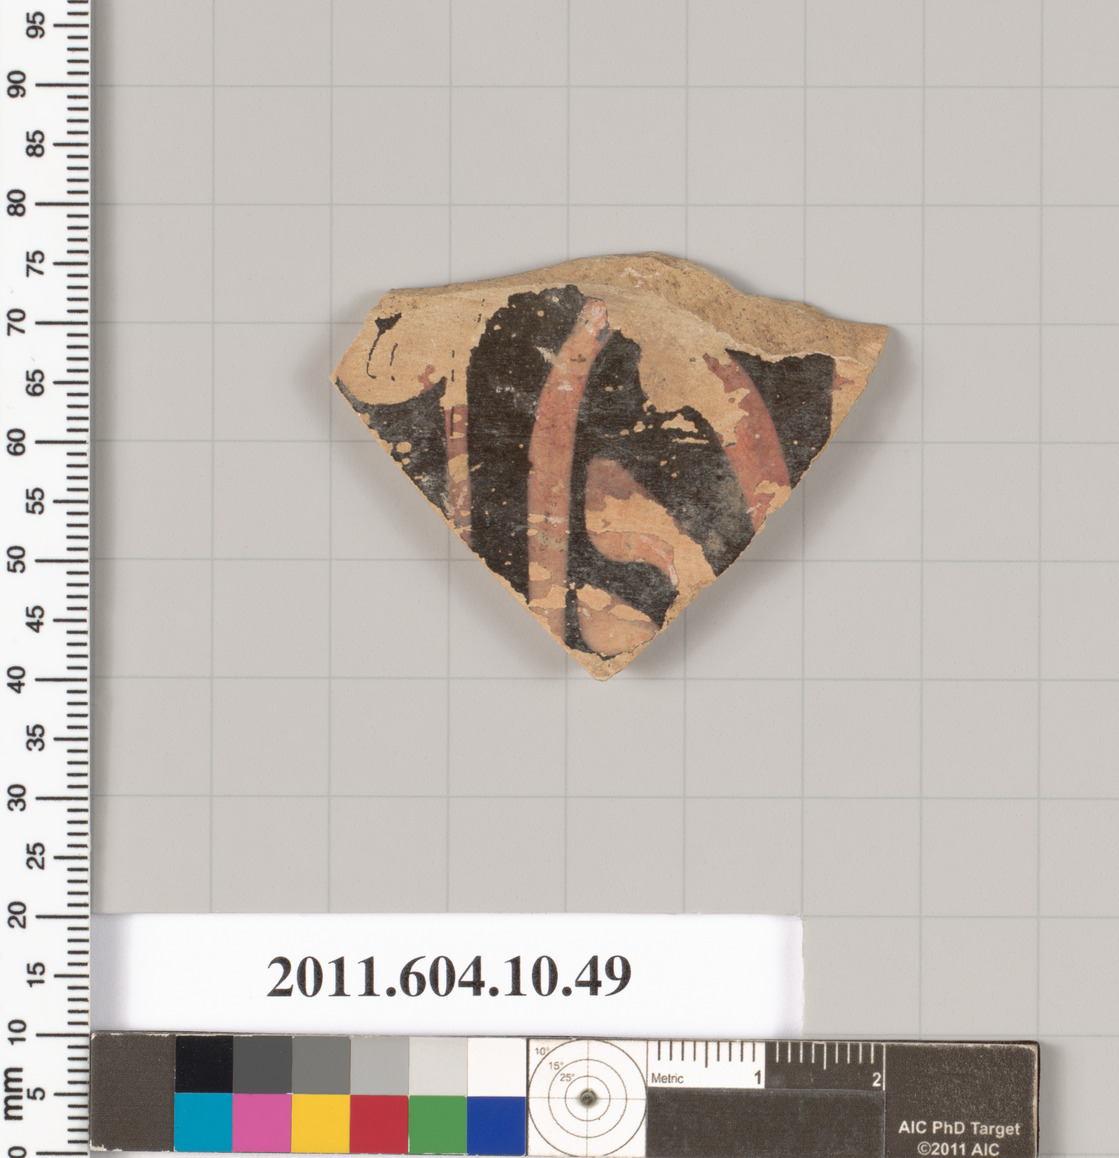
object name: kylix fragment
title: Terracotta fragment of a kylix (drinking cup)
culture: etruscan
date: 334-301 BCE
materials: terracotta